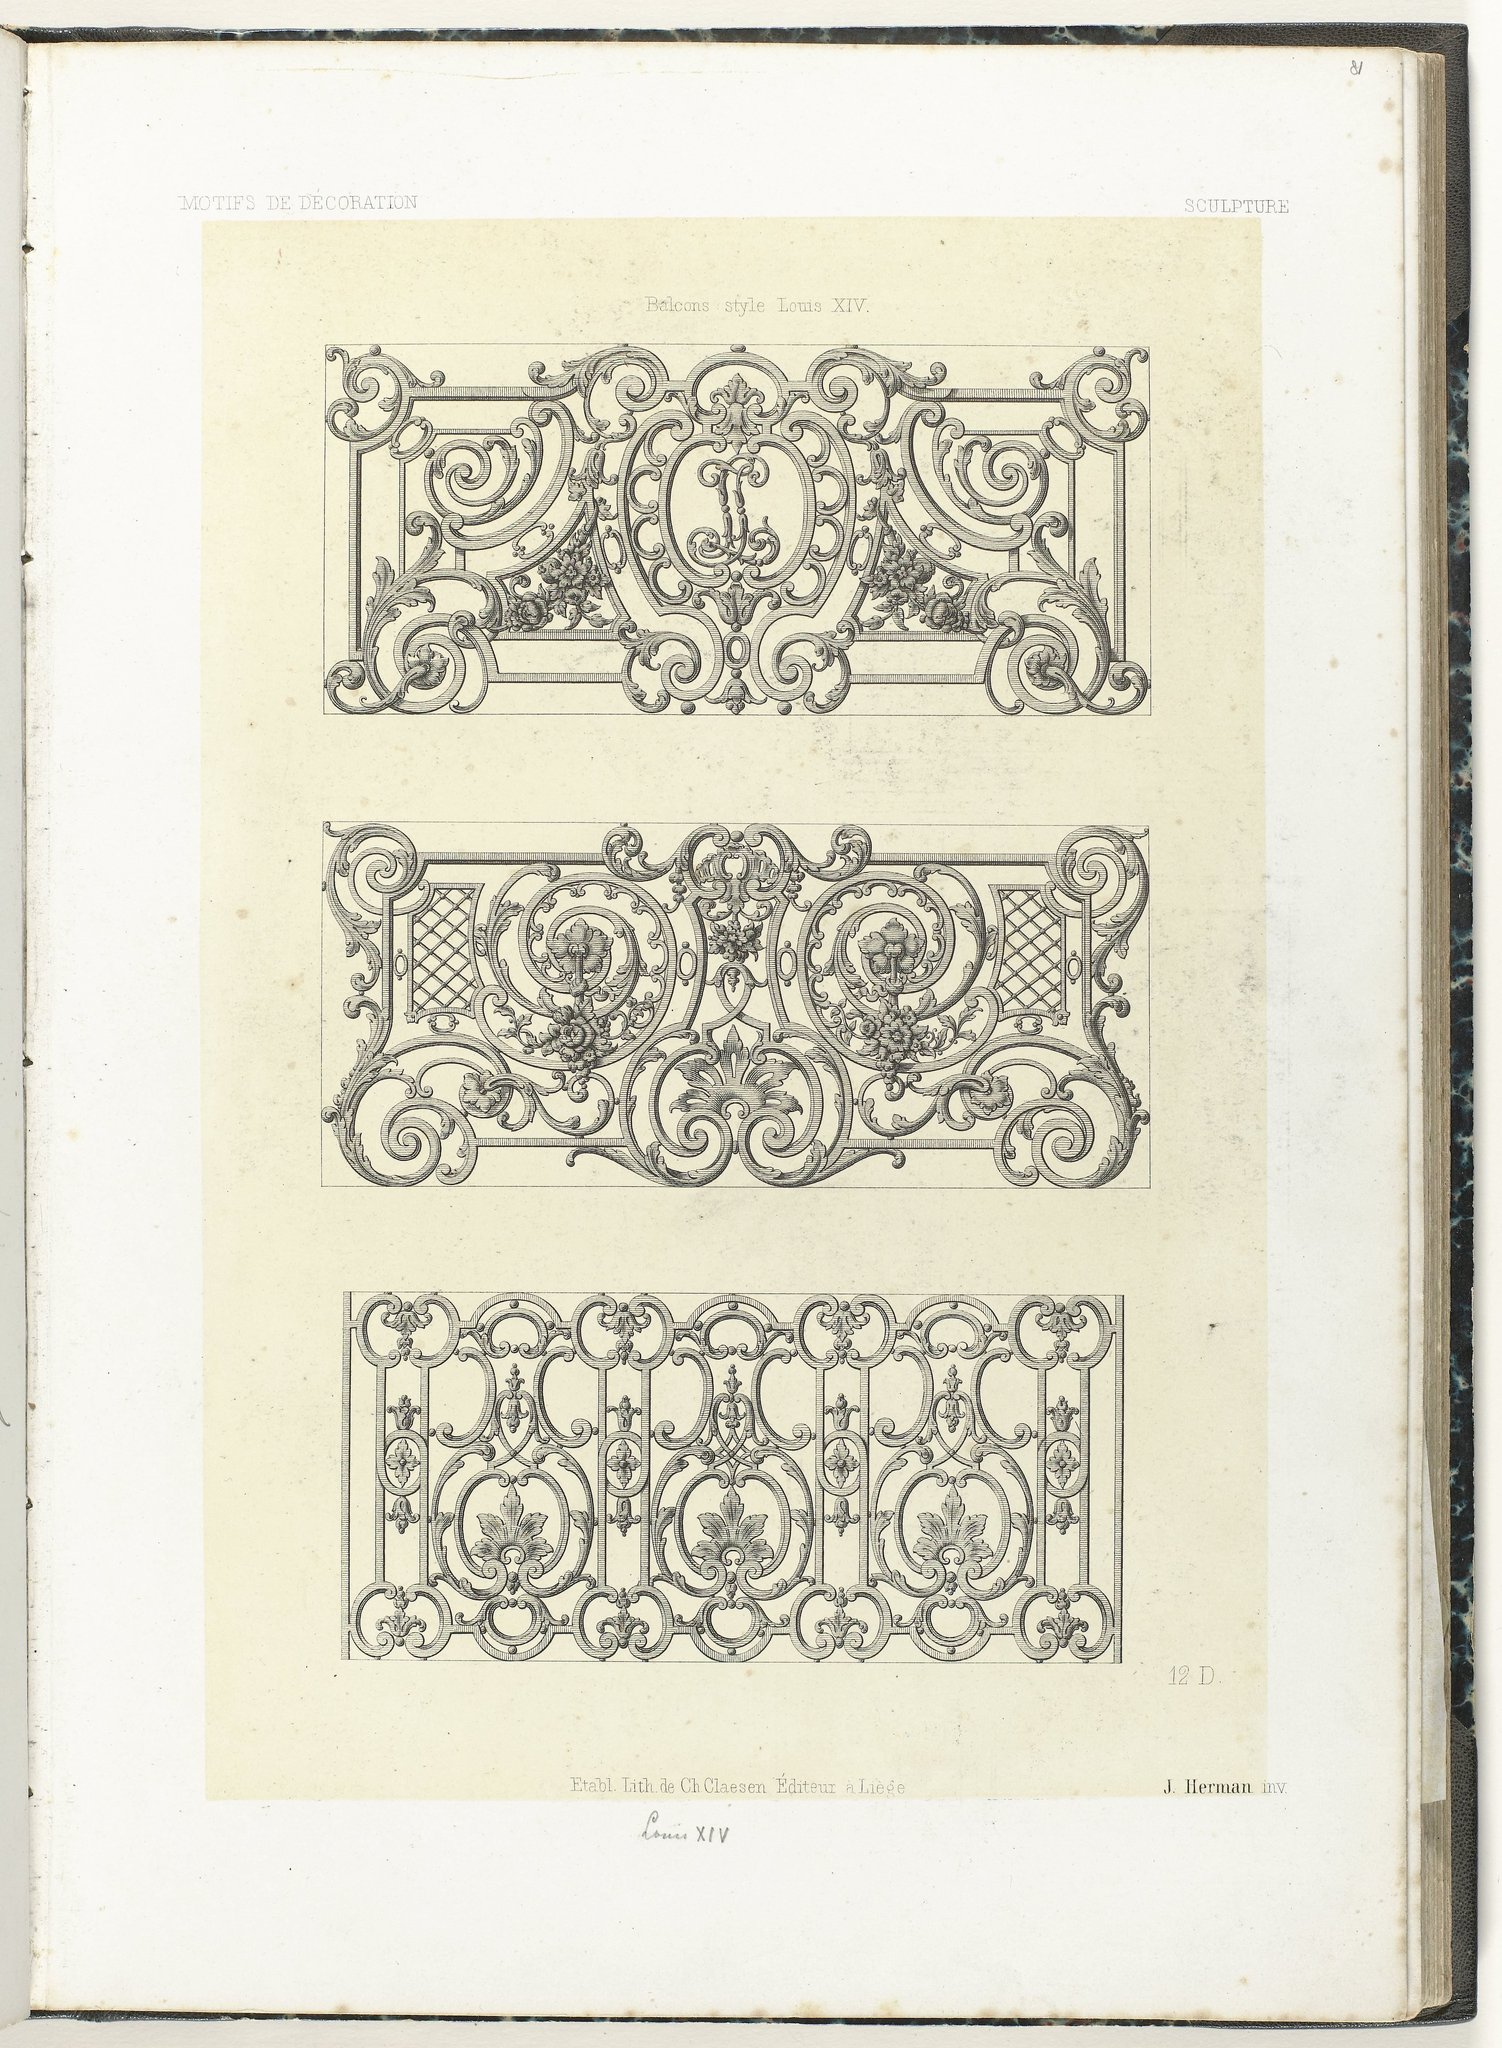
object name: print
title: Balcons style Louis XIV.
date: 1866-1900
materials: paper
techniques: tone lithography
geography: liège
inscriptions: annotation: ‘Louis XIV’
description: Balkons in de stijl van Louis XIV. Linksboven staat vermeld: Motifs de Décoration, rechtsboven: Sculpture, rechtsonder: 12 D.